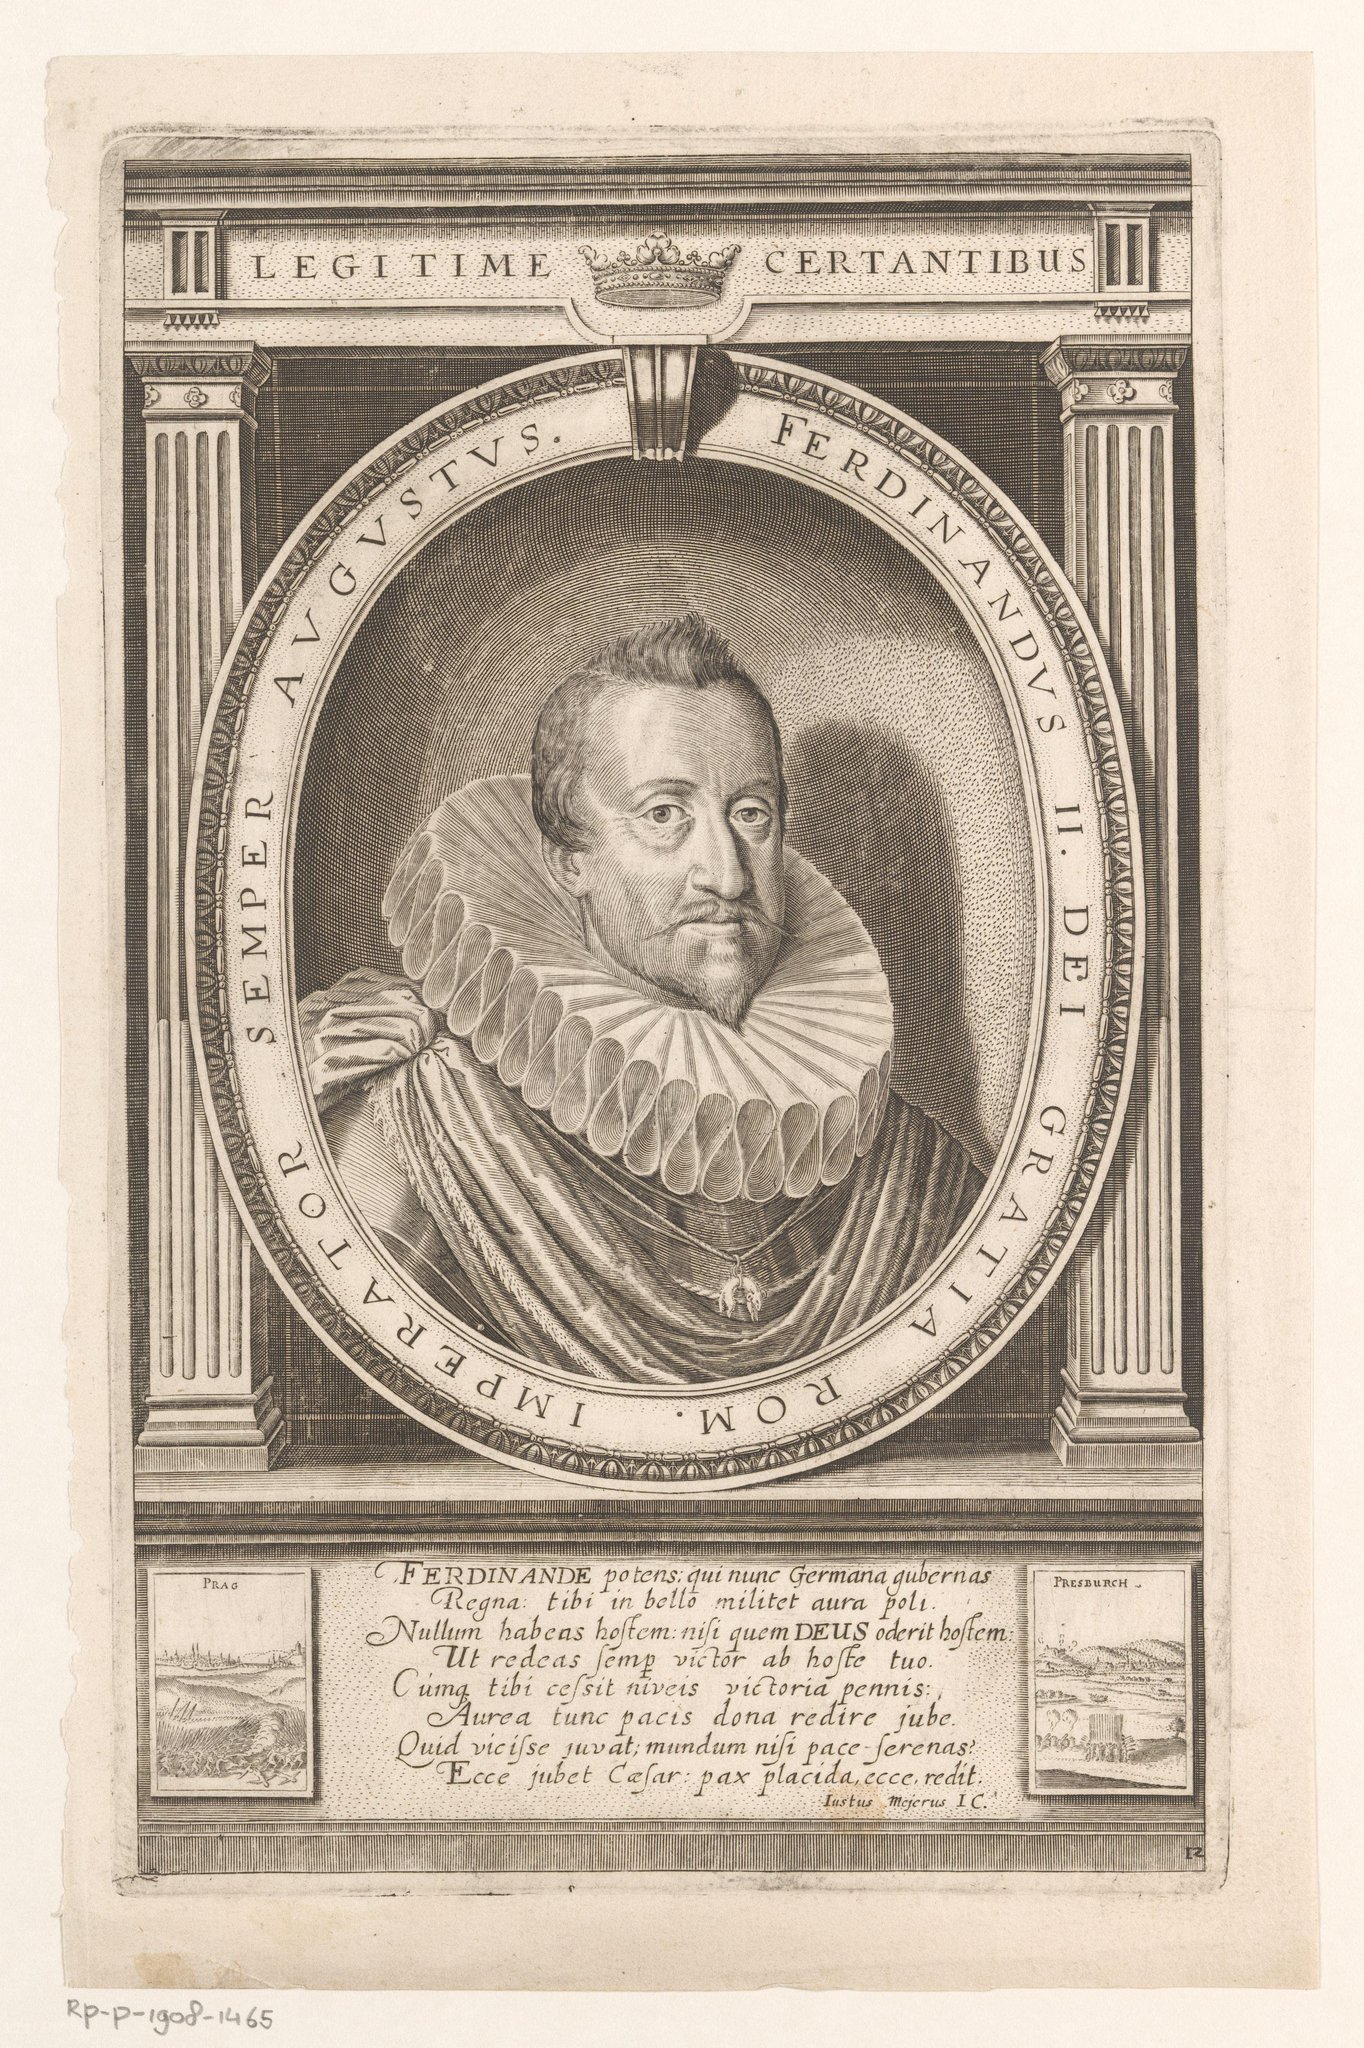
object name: print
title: Portret van Ferdinand II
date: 1660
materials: paper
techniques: engraving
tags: vienna, ferdinand ii (duits keizer), historical persons, battle, ruler, sovereign, knighthood order of the golden fleece - insignia of a knighthood order, e.g.: badge, chain (with name of order)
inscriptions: collector's mark: Lugt 2228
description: Prent uit: Aquila Austriaca Das ist Historische Beschreibung und Abbildungen Aller Römischen Kaiser und Könige (...). Neurenberg: Paul Fürst, [1660].